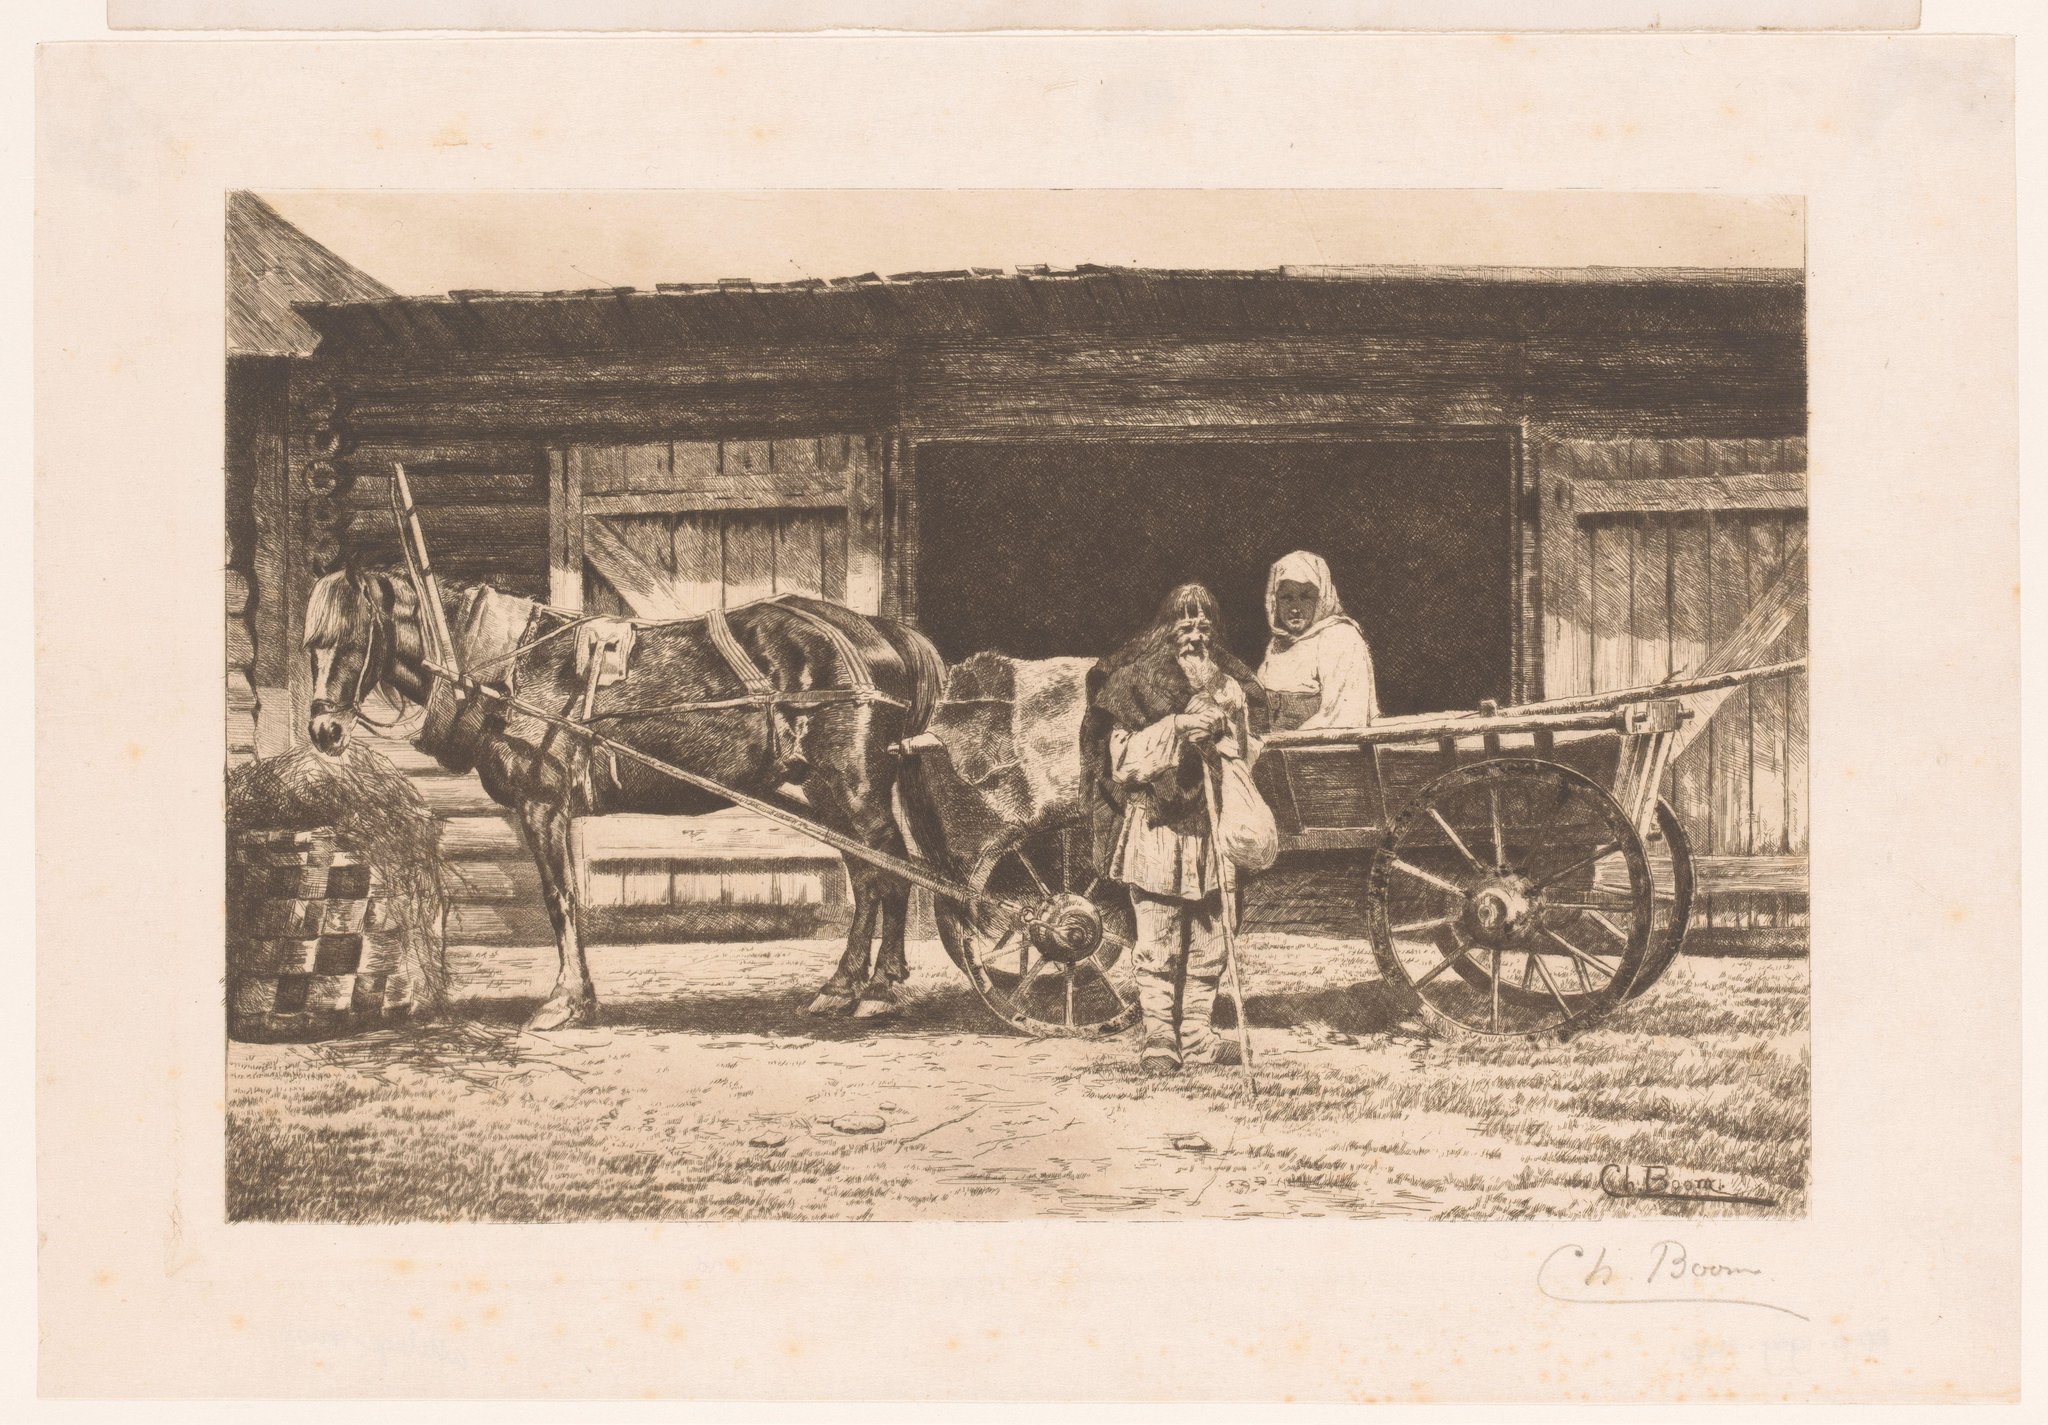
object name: print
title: Man en vrouw met paard en wagen voor een schuur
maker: charles boom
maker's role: print maker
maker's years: 1858-1939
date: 1868-1909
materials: paper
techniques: etching, intaglio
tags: (farm) wagon, freight wagon, cart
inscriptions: collector's mark: Lugt 2228, mark: ‘Antwerpsche Etsers 1880’